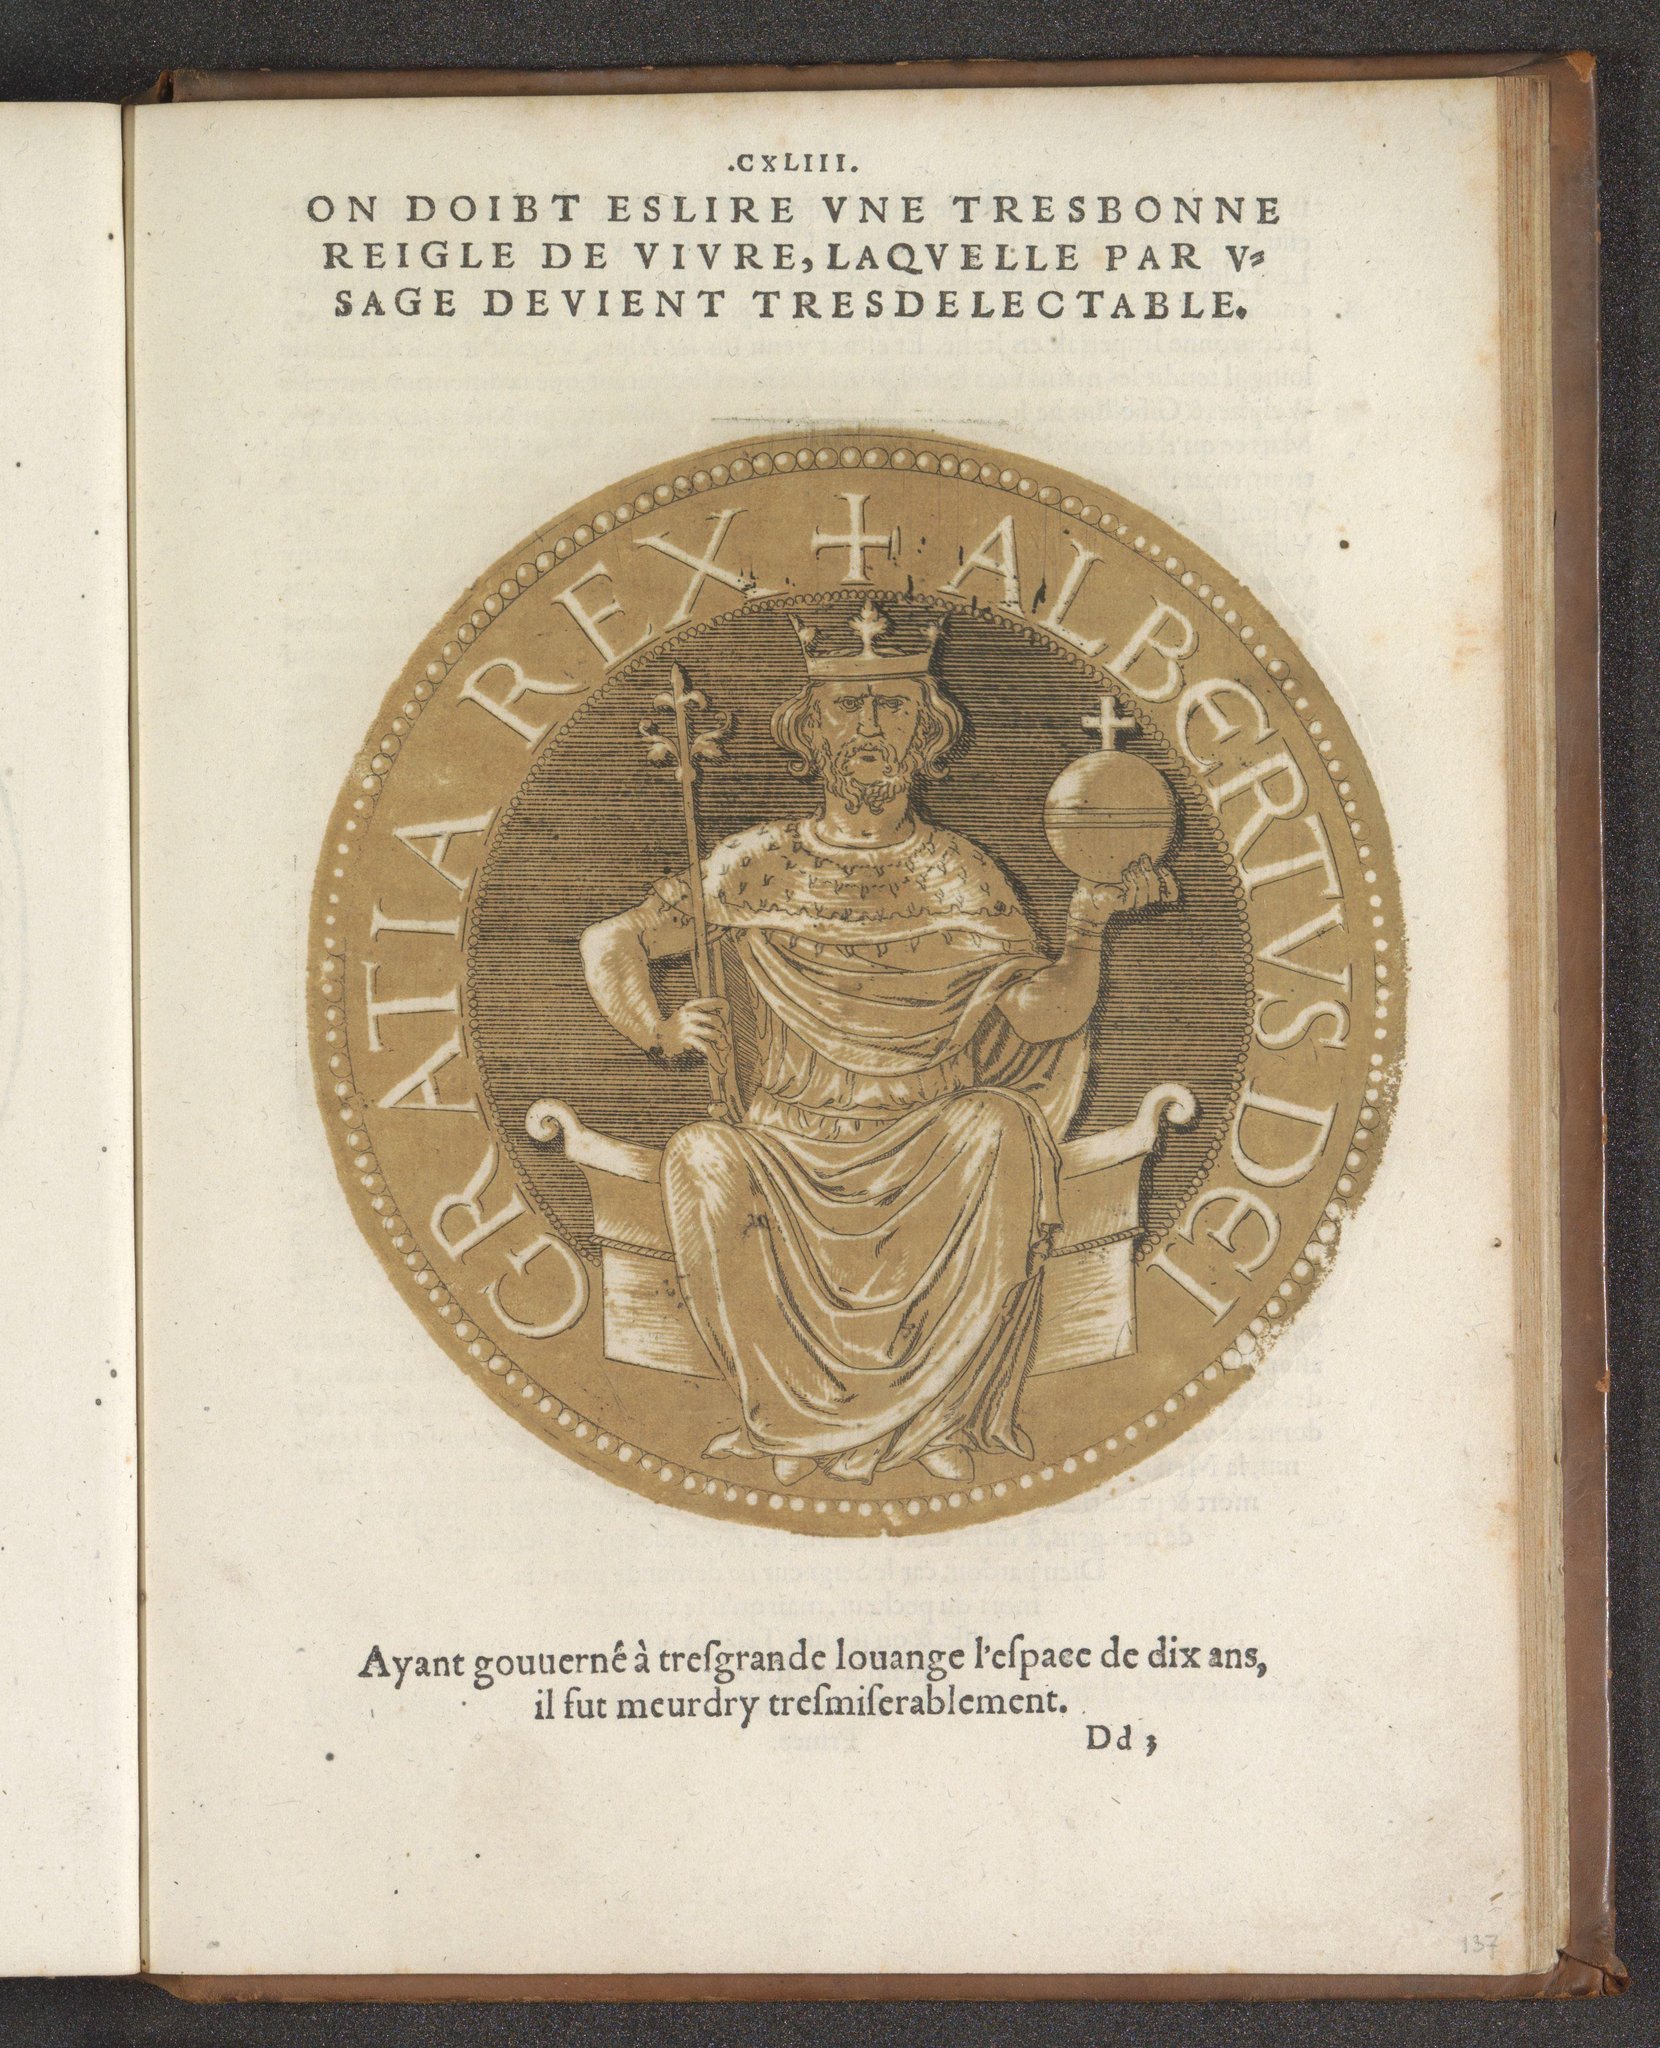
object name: print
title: Les images presque de tous les empereurs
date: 1557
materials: paper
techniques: woodcut, etching, letterpress printing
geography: antwerp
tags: emperor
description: Portret van rooms-koning Albrecht I, op een munt met randschrift. De prent maakt deel uit van een boek over de keizers vanaf Julius Caesar tot en met Karel V en zijn broer Ferdinand.